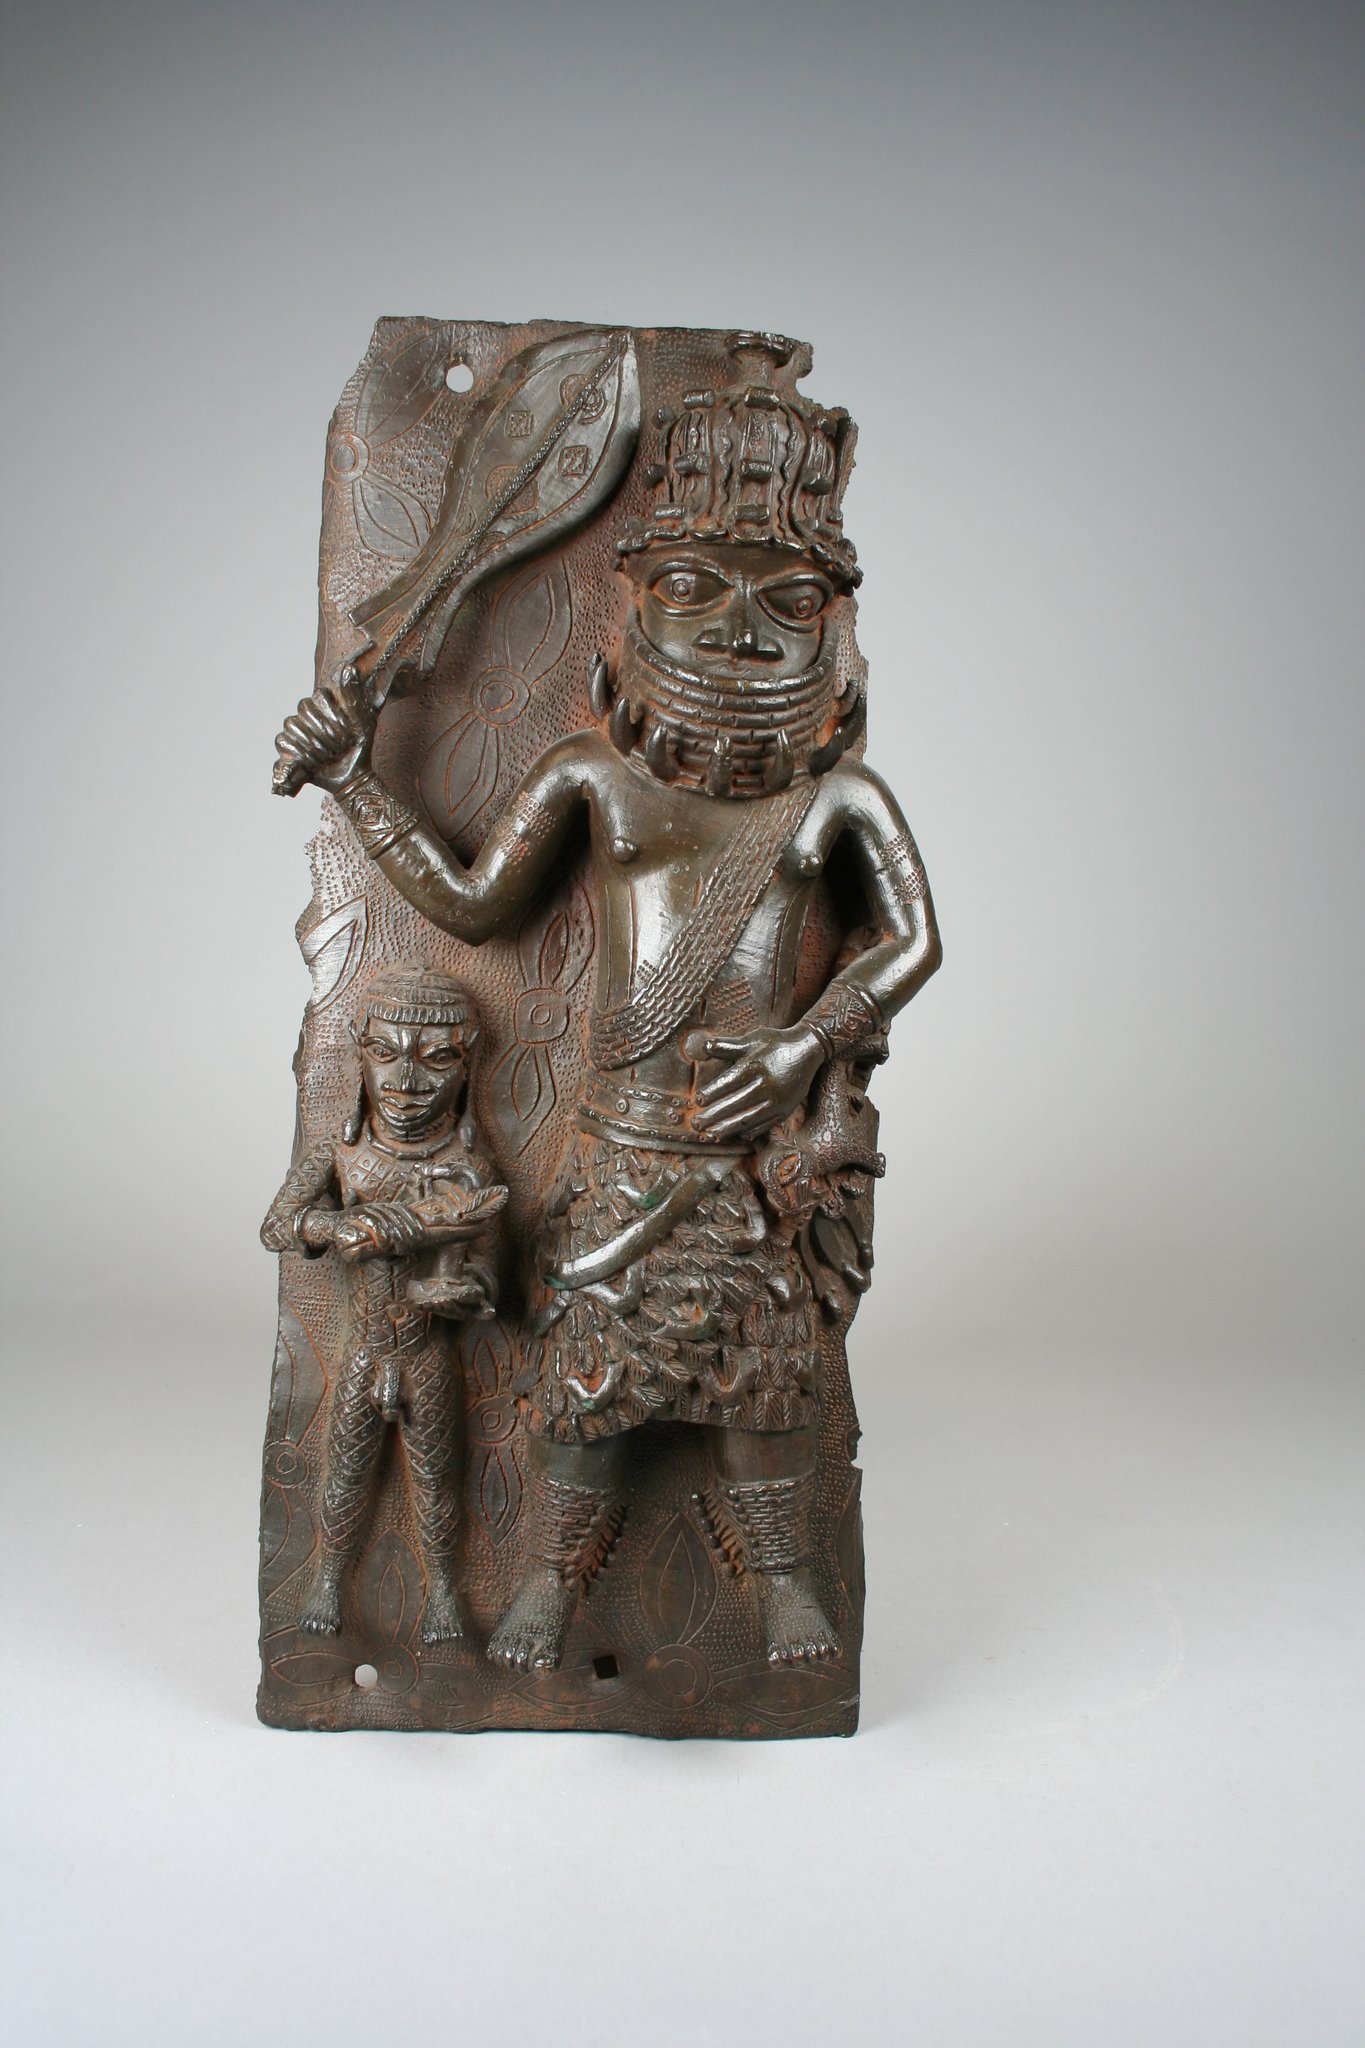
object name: plaque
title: Plaque with Ìyàsẹ́ (Royal Commander) and Attendant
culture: edo period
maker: ìgùn ẹ́rọ̀nwwọ̀n (brass-casting guild) artists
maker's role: artist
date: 1540-1570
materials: brass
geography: nigeria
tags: men